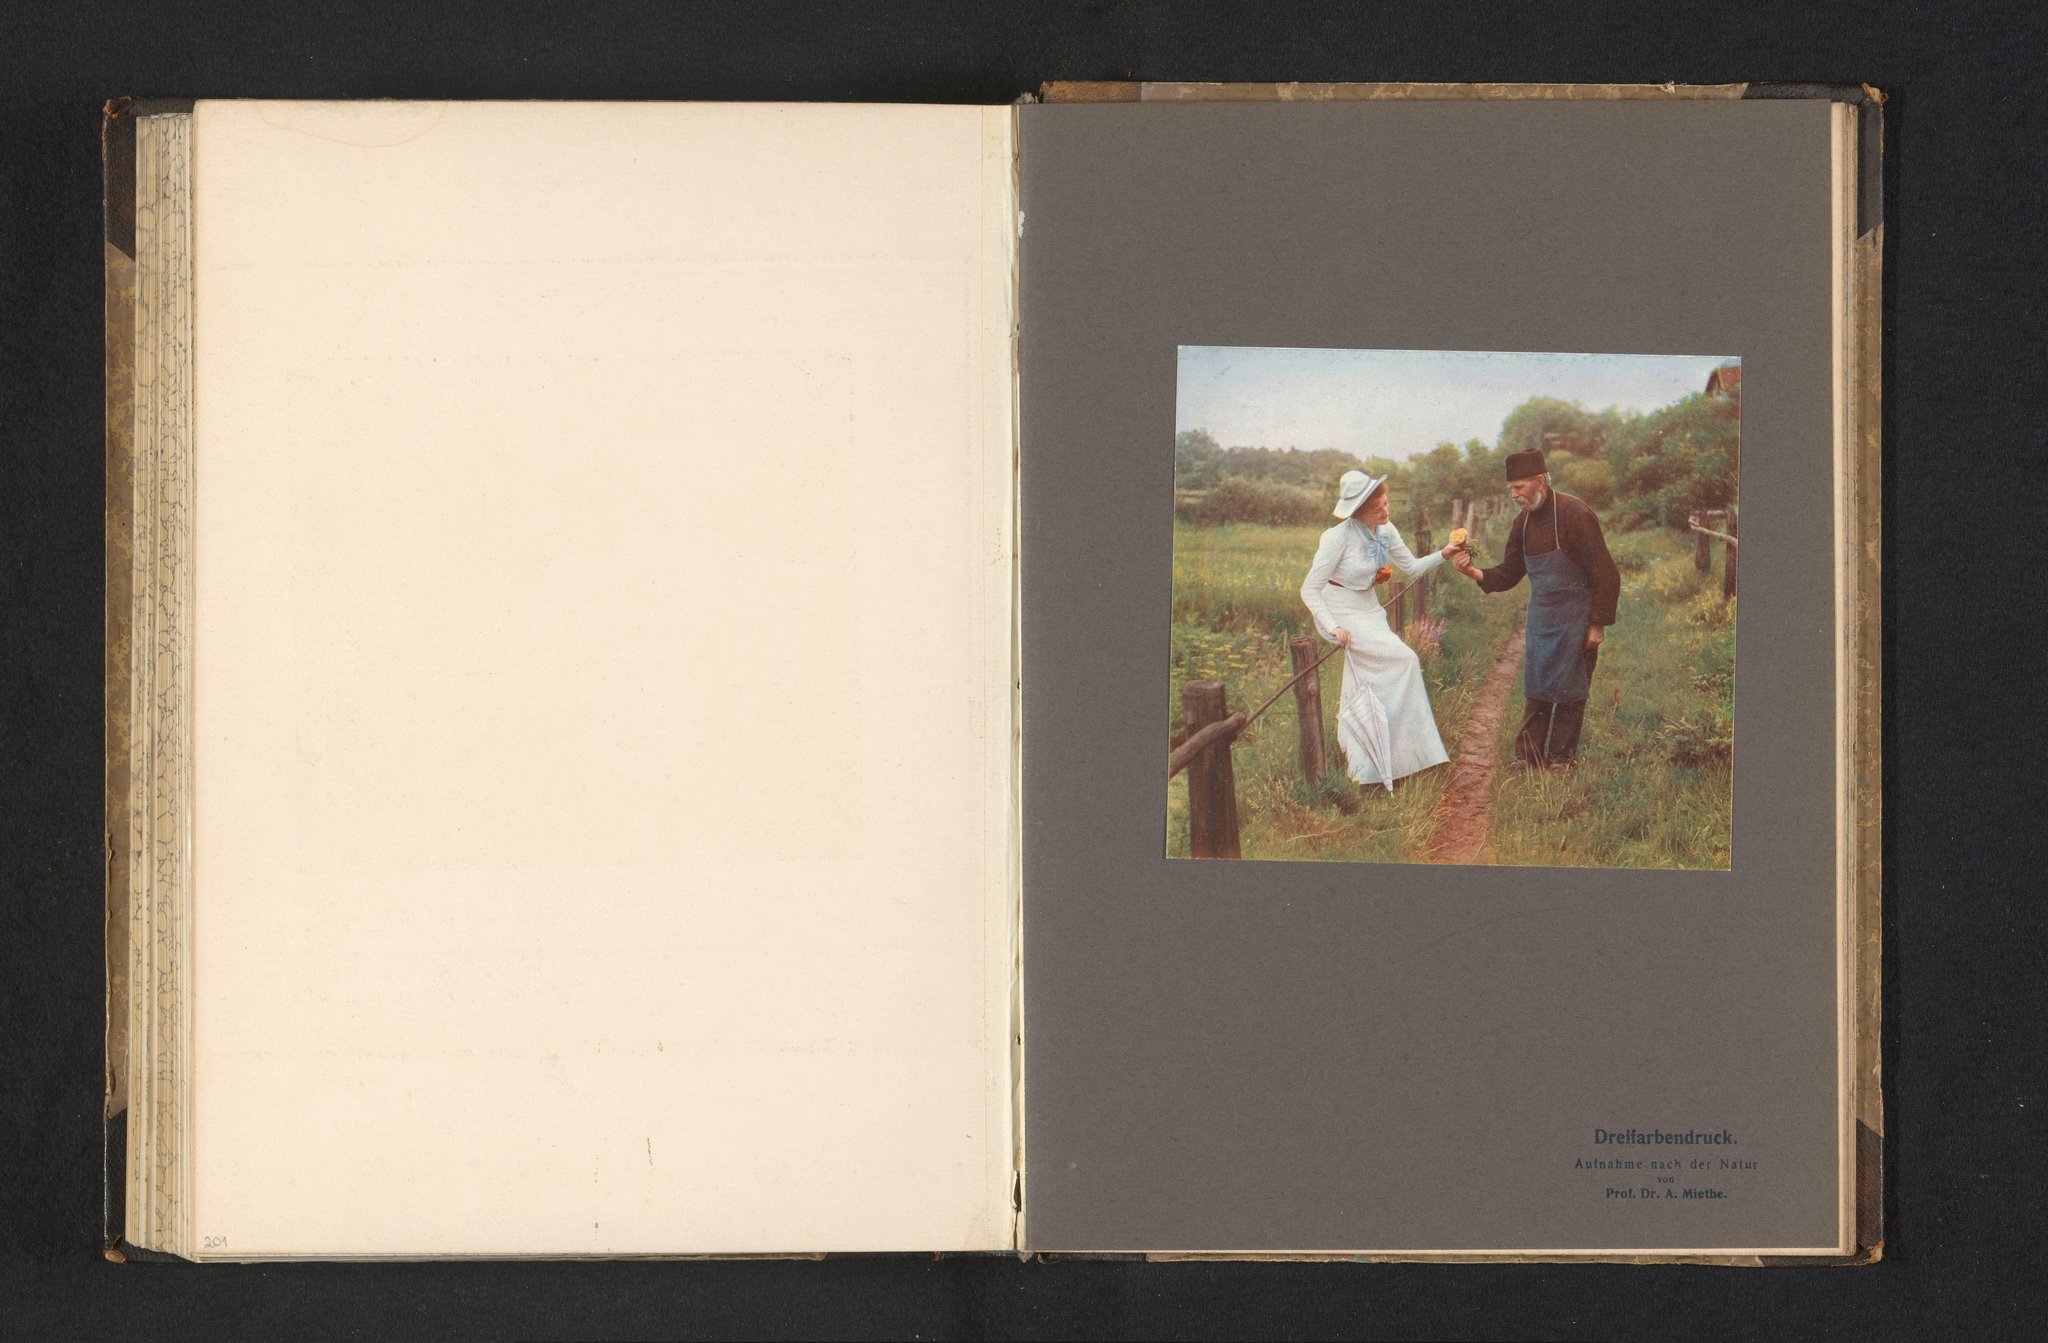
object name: page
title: Man overhandigt een bloem aan een vrouw op een pad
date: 1898-1903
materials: paper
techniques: three-color autotype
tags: cut flowers; nosegay, bunch of flowers, adult woman, adult man, road, path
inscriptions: inscription: ‘Dreifarbendruck./ Aufnahme nach der Natur/ von/ Prof. Dr. A. Miethe’, monogram: ‘LEIPZIG/ S G’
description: Prent drie van veertien prenten achterin het boek.